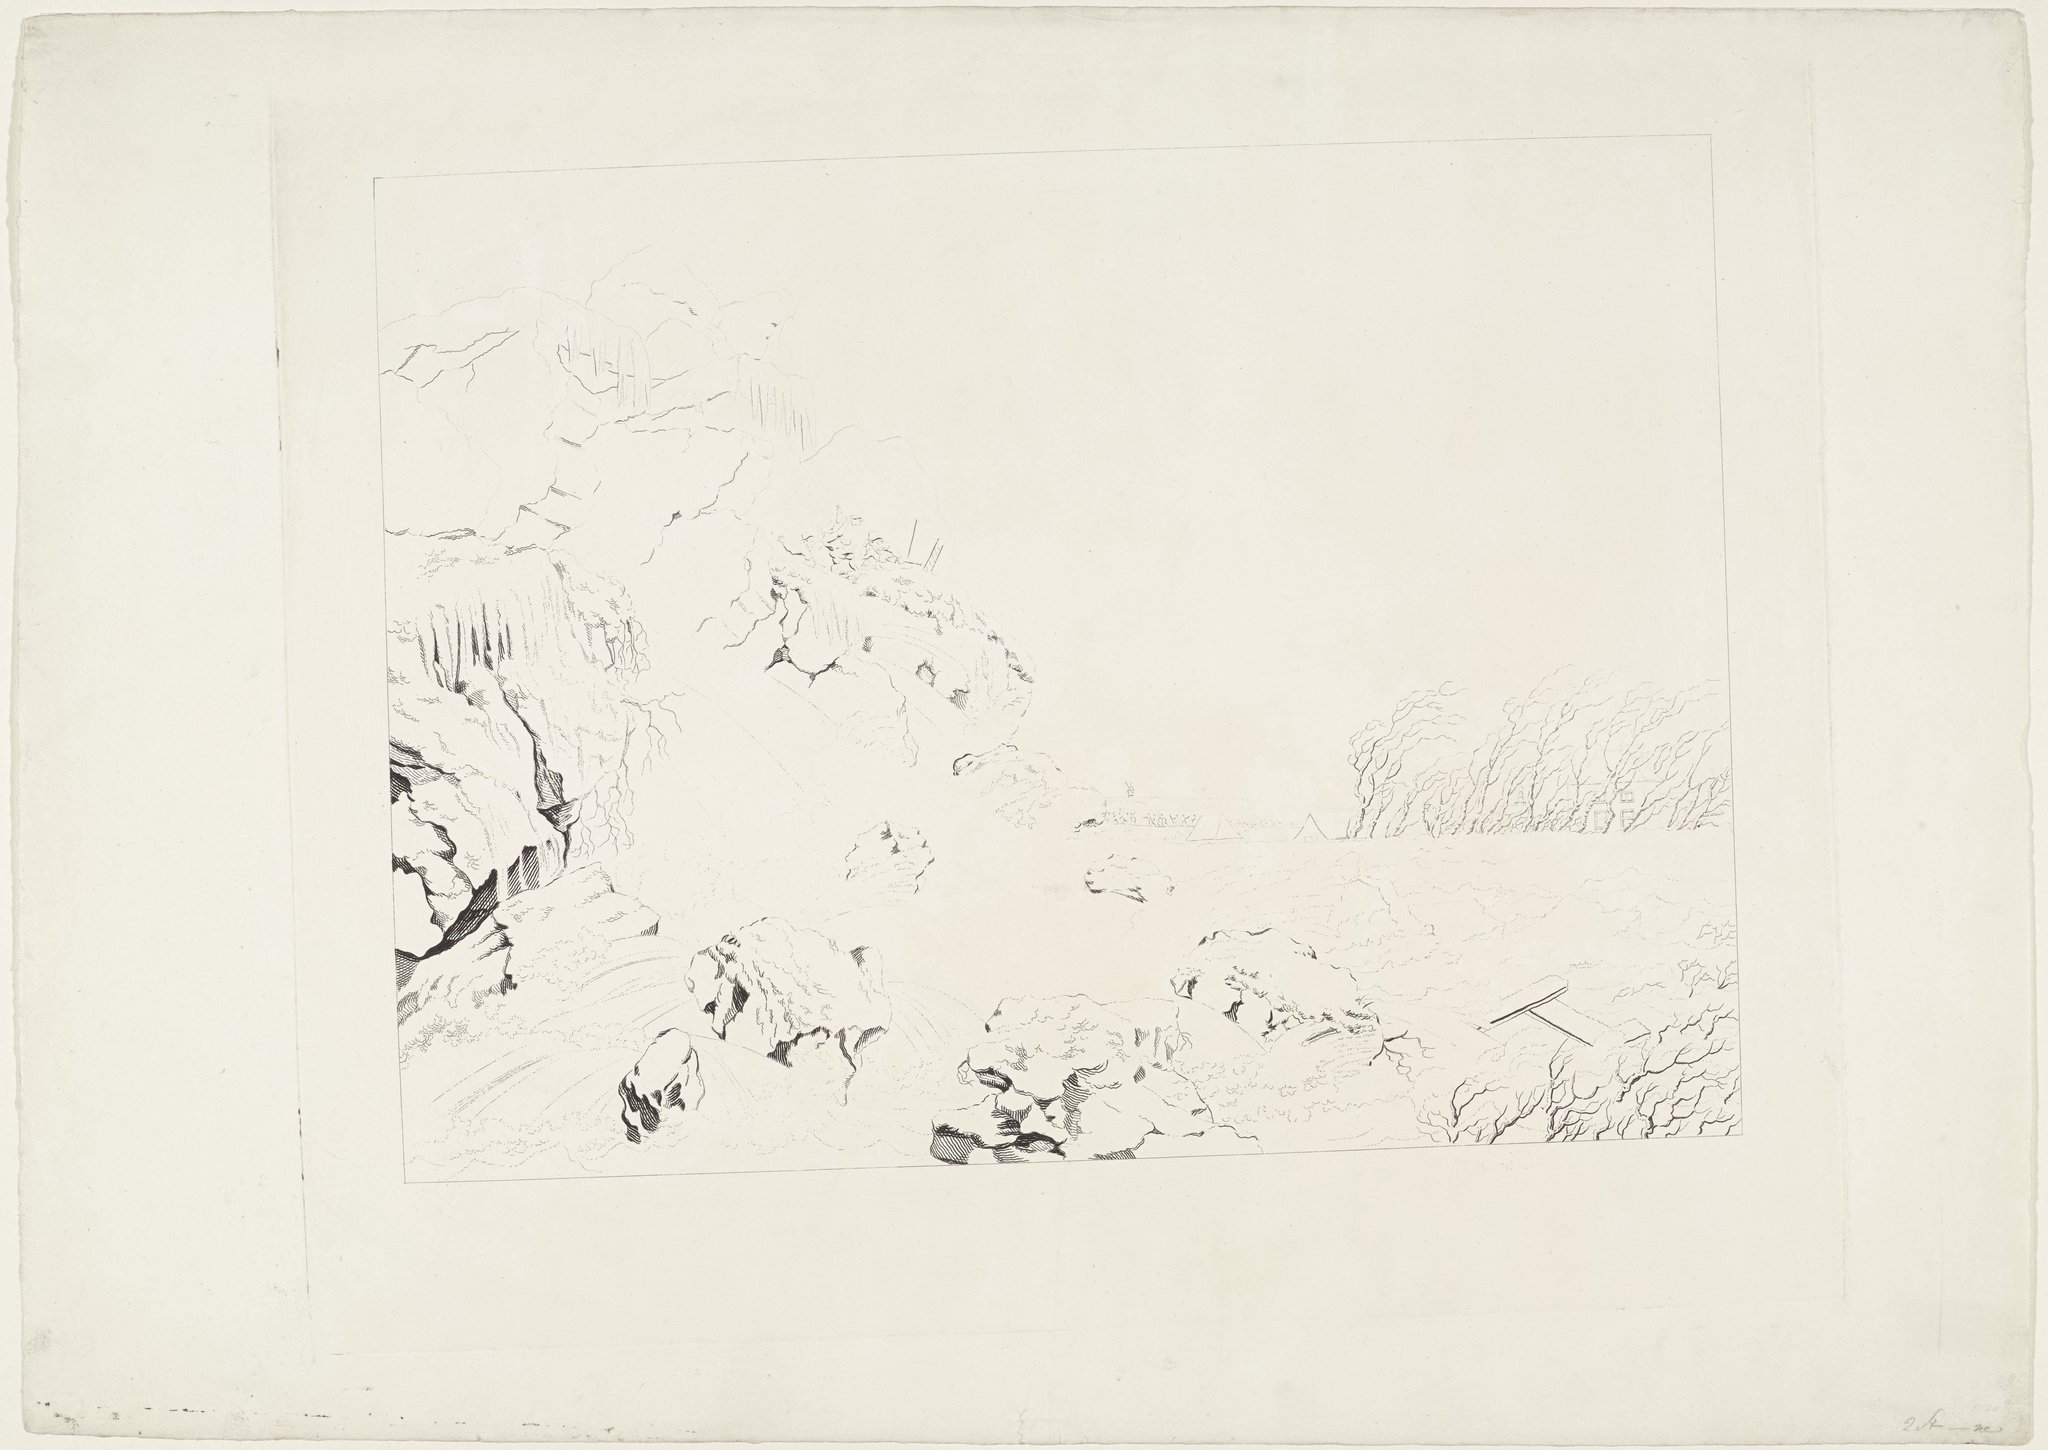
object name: print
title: Dijkdoorbraak te Bemmel, 1799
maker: christiaan josi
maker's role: draughtsman, print maker, publisher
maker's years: 1765-1828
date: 1802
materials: paper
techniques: etching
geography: amsterdam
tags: dike-break, drift ice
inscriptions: collector's mark: Lugt 2228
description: Doorbraak van de dijk te Bemmel en overstroming van het land, veroorzaakt door opeenhoping van ijsschotsen in de rivier de Waal, 27 februari 1799. Zie ook de pendant.